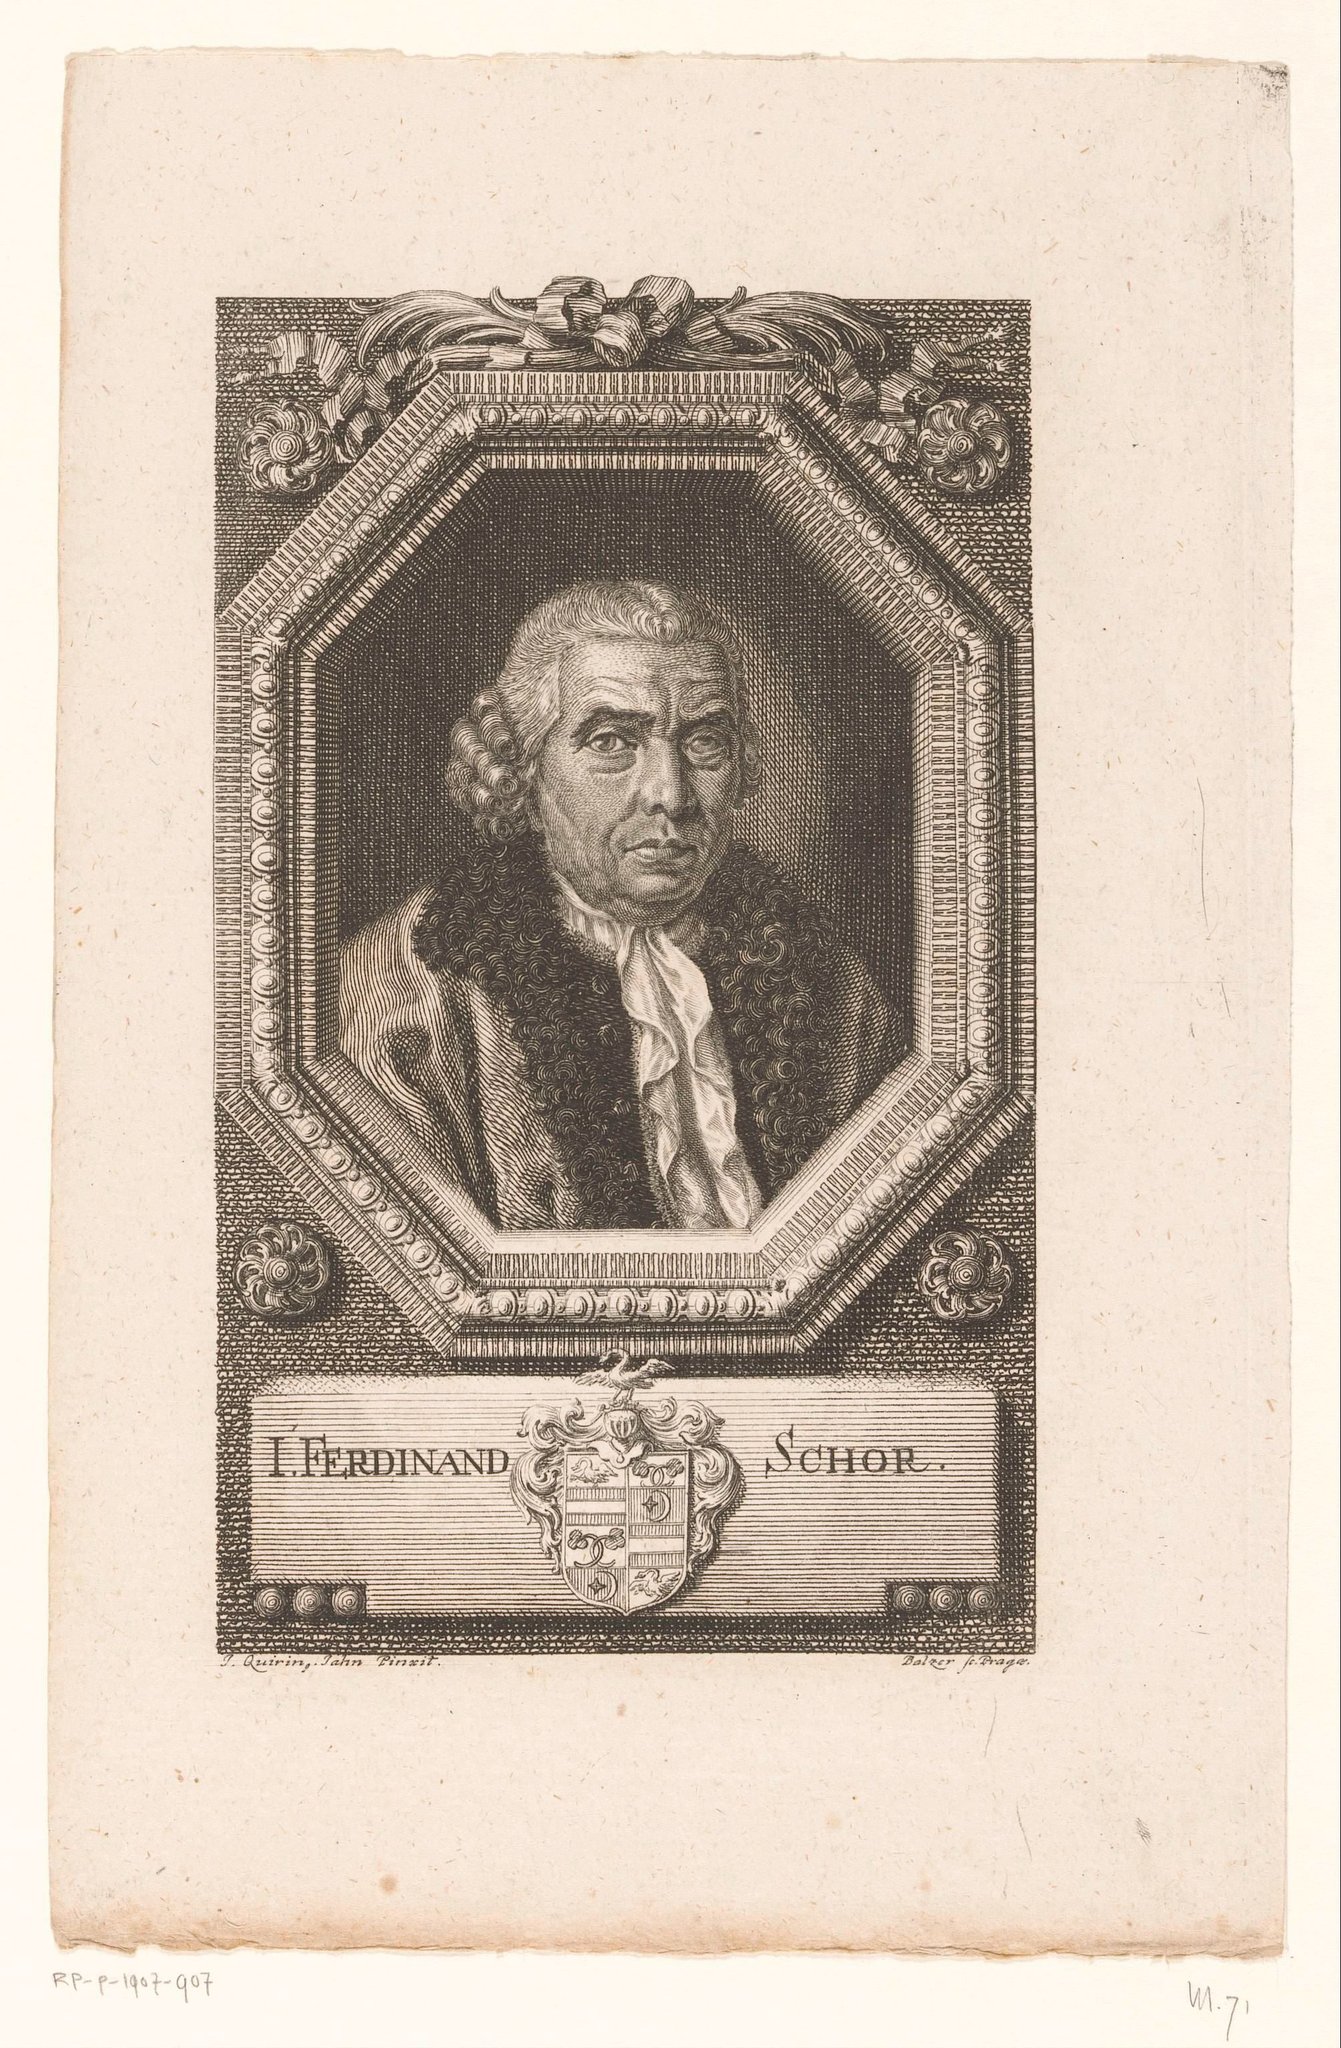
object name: print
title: I. Ferdinand Schor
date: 1749-1799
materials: paper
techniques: engraving, etching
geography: prague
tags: prague, painter, engineer, historical persons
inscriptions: collector's mark: Lugt 2228